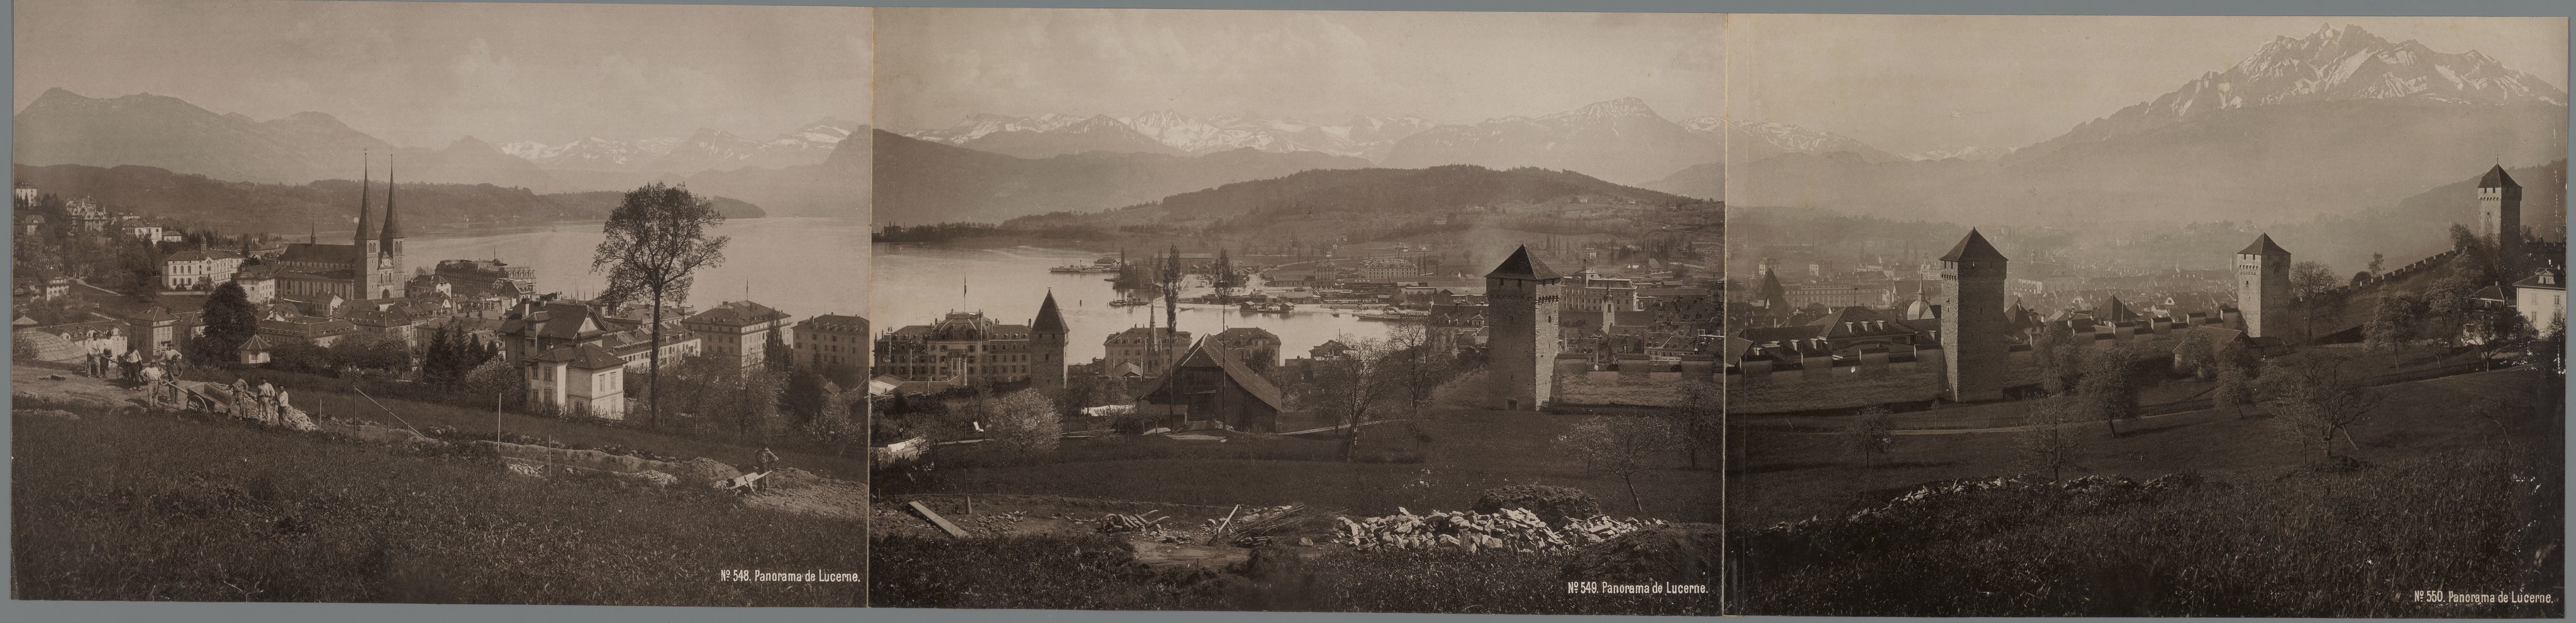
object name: panorama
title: Panorama van Luzern en het Vierwoudstrekenmeer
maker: Anonymous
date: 1870-1895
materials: paper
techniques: photograph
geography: zurich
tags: city-view in general; 'veduta', lake, city-walls, mountain-range, snow peaks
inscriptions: number: ‘No 548./ No 549./ No 550.’, collector's mark: ‘VOSMAER’